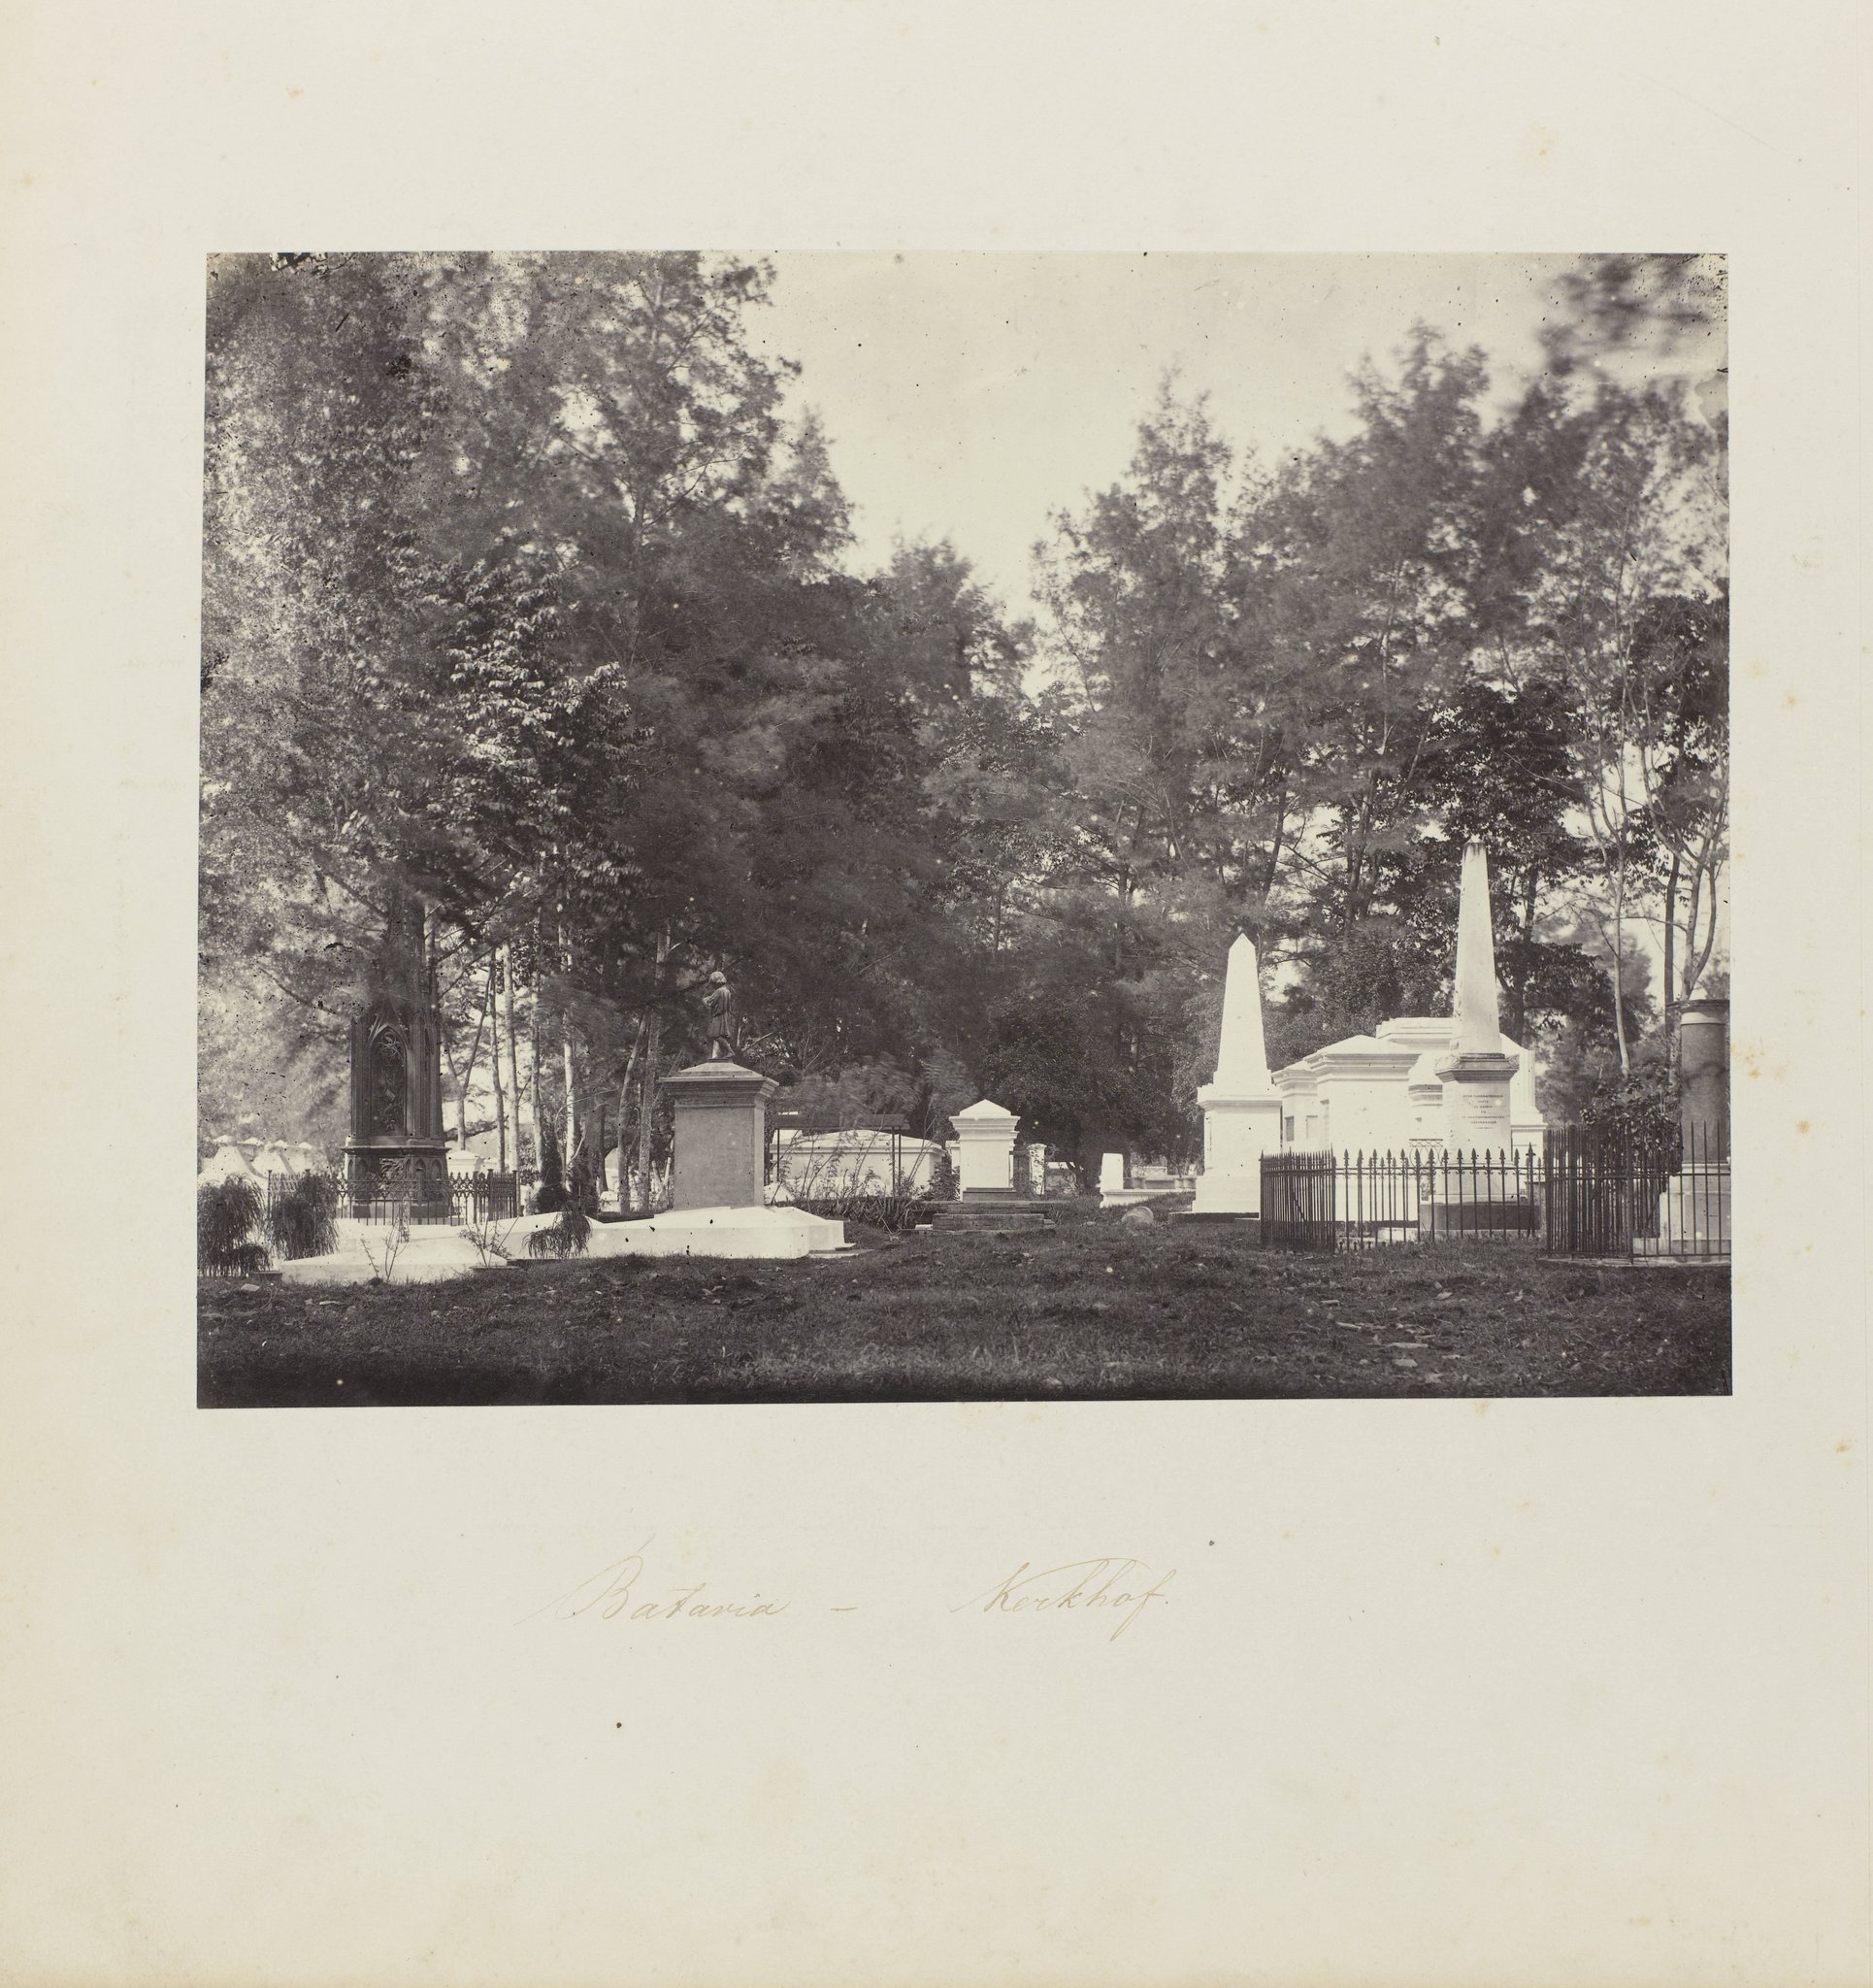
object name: photograph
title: Batavia - Kerkhof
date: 1863-1866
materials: photographic support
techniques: albumen print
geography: batavia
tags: churchyard, cemetery, batavia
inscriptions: inscription: ‘Batavia - Kerkhof’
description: Het Europese kerkhof in Tanah Abang, Batavia. Onderdeel van het rode fotoalbum met foto's van Java, uit het bezit van apotheker Specht-Grijp, die in 1865 vanuit Batavia naar Nederland terugkeerde.